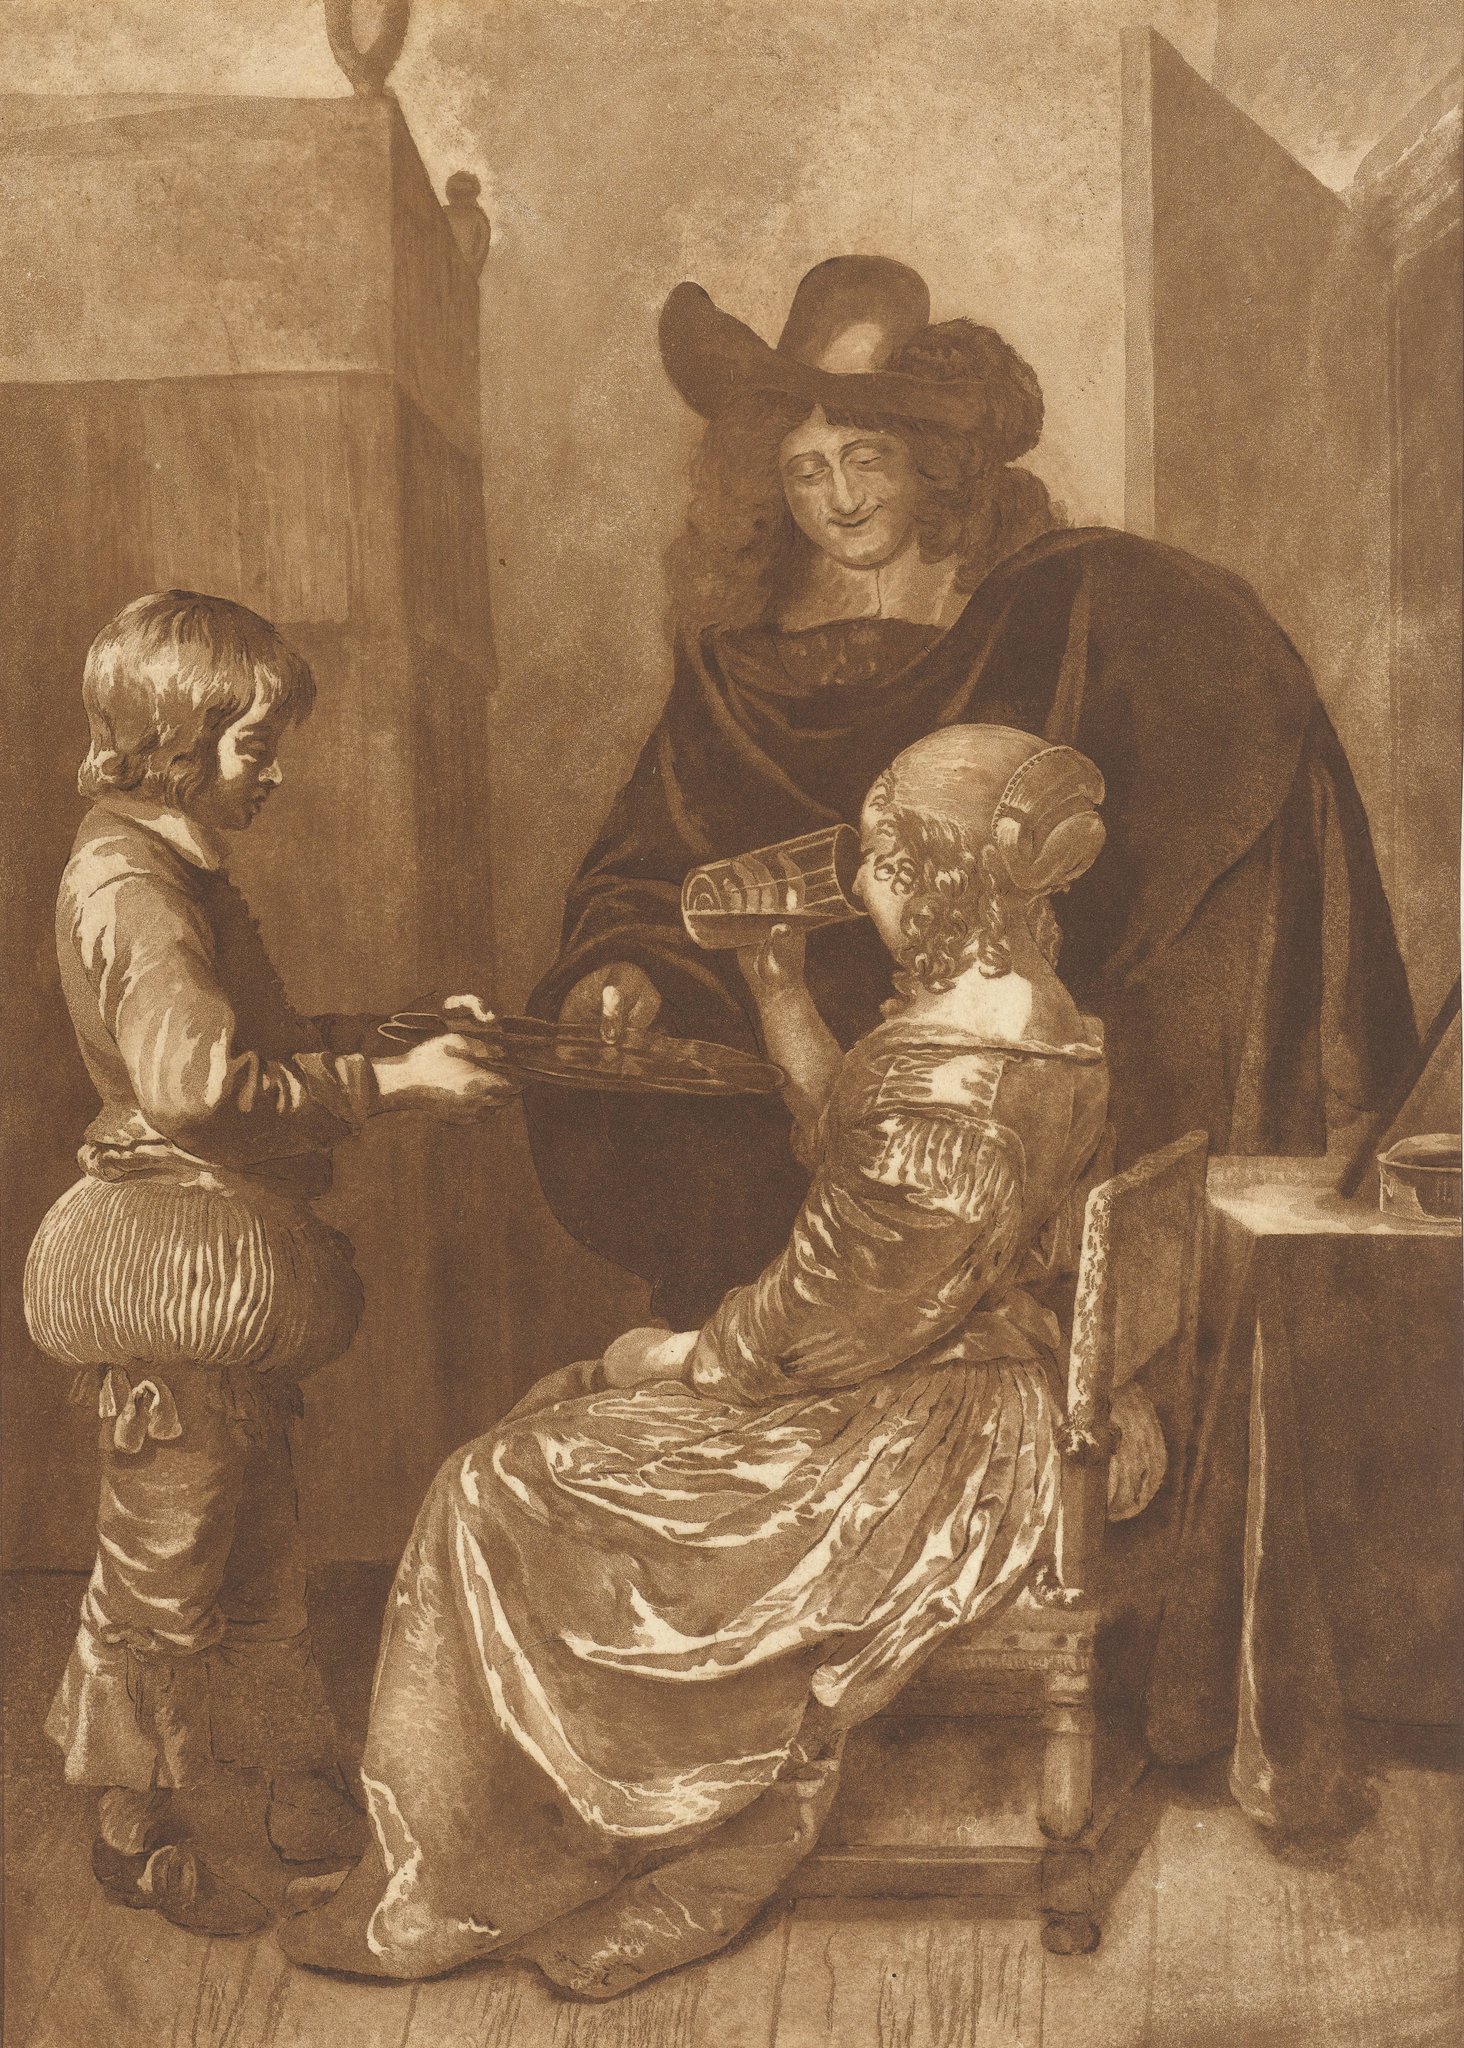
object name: print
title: Heer en dame met page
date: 1779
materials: paper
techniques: printing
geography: amsterdam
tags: serving-dish, platter, glass, rummer, house personnel, servants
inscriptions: inscription: ‘Gerard te Burg del. Ploos van Amstel. J.C. Fecit. 1779.’, collector's mark: Lugt 240, collector's mark: Lugt 2725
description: Een page presenteert een dienblad aan een dame en heer. De vrouw drinkt uit het glas.